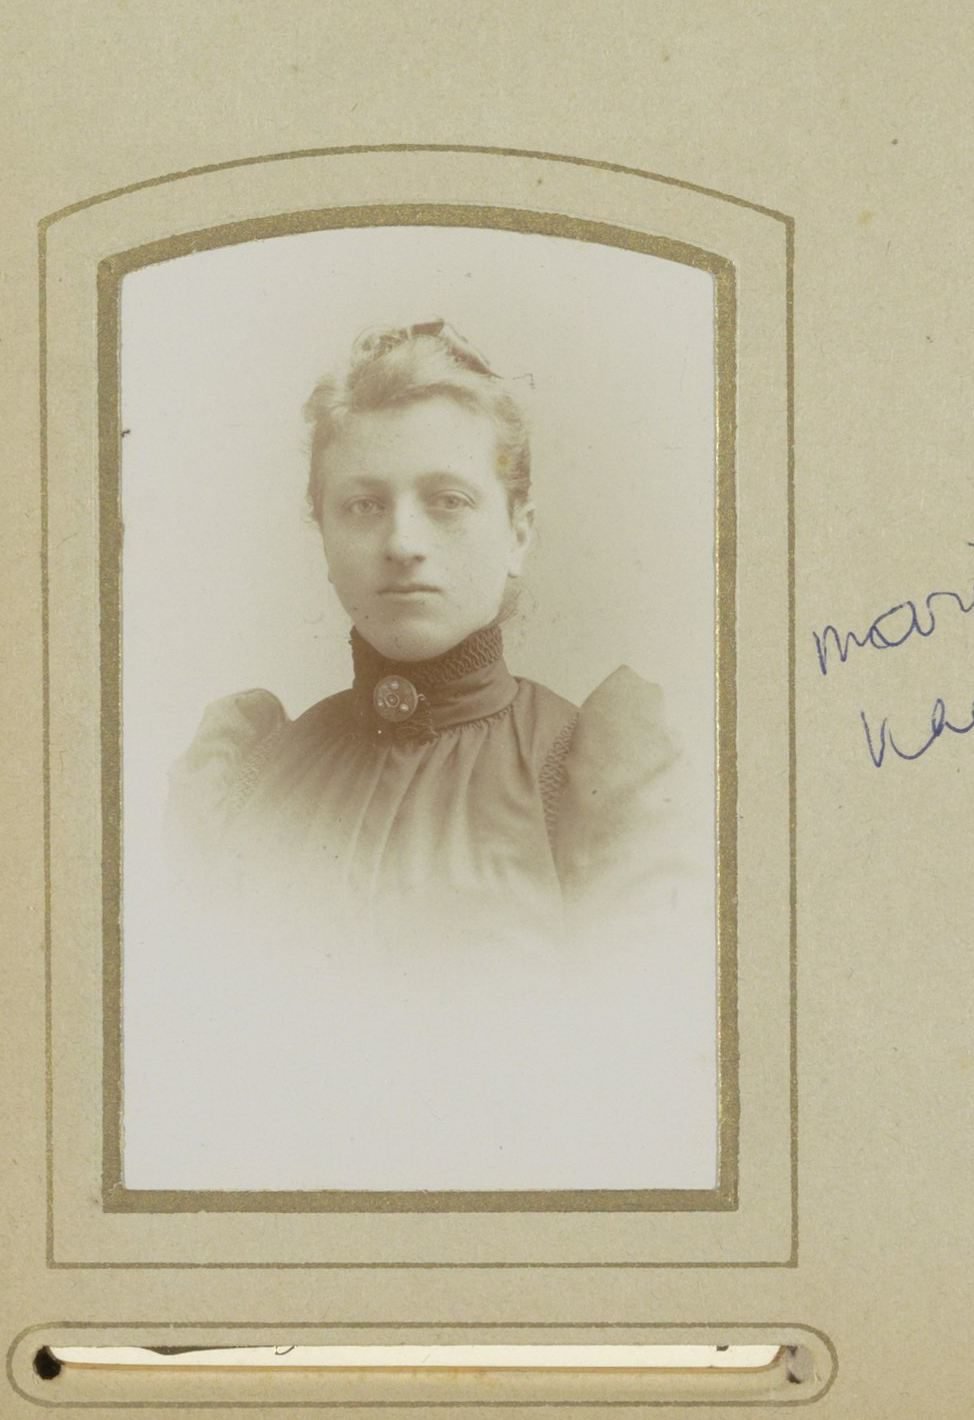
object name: carte de visite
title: Portret van Marie Schmidt van Gelder-Kaars Sypesteyn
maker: max büttinghausen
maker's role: fotograaf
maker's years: 1847-1906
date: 1887-1906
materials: cardboard, paper, photographic support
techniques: collodion silver print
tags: adult woman, historical persons - bb - woman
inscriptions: address: ‘M. Büttinghausen Amsterdam, Godesberg.’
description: Onderdeel van Fotoalbum van de familie Boelen.